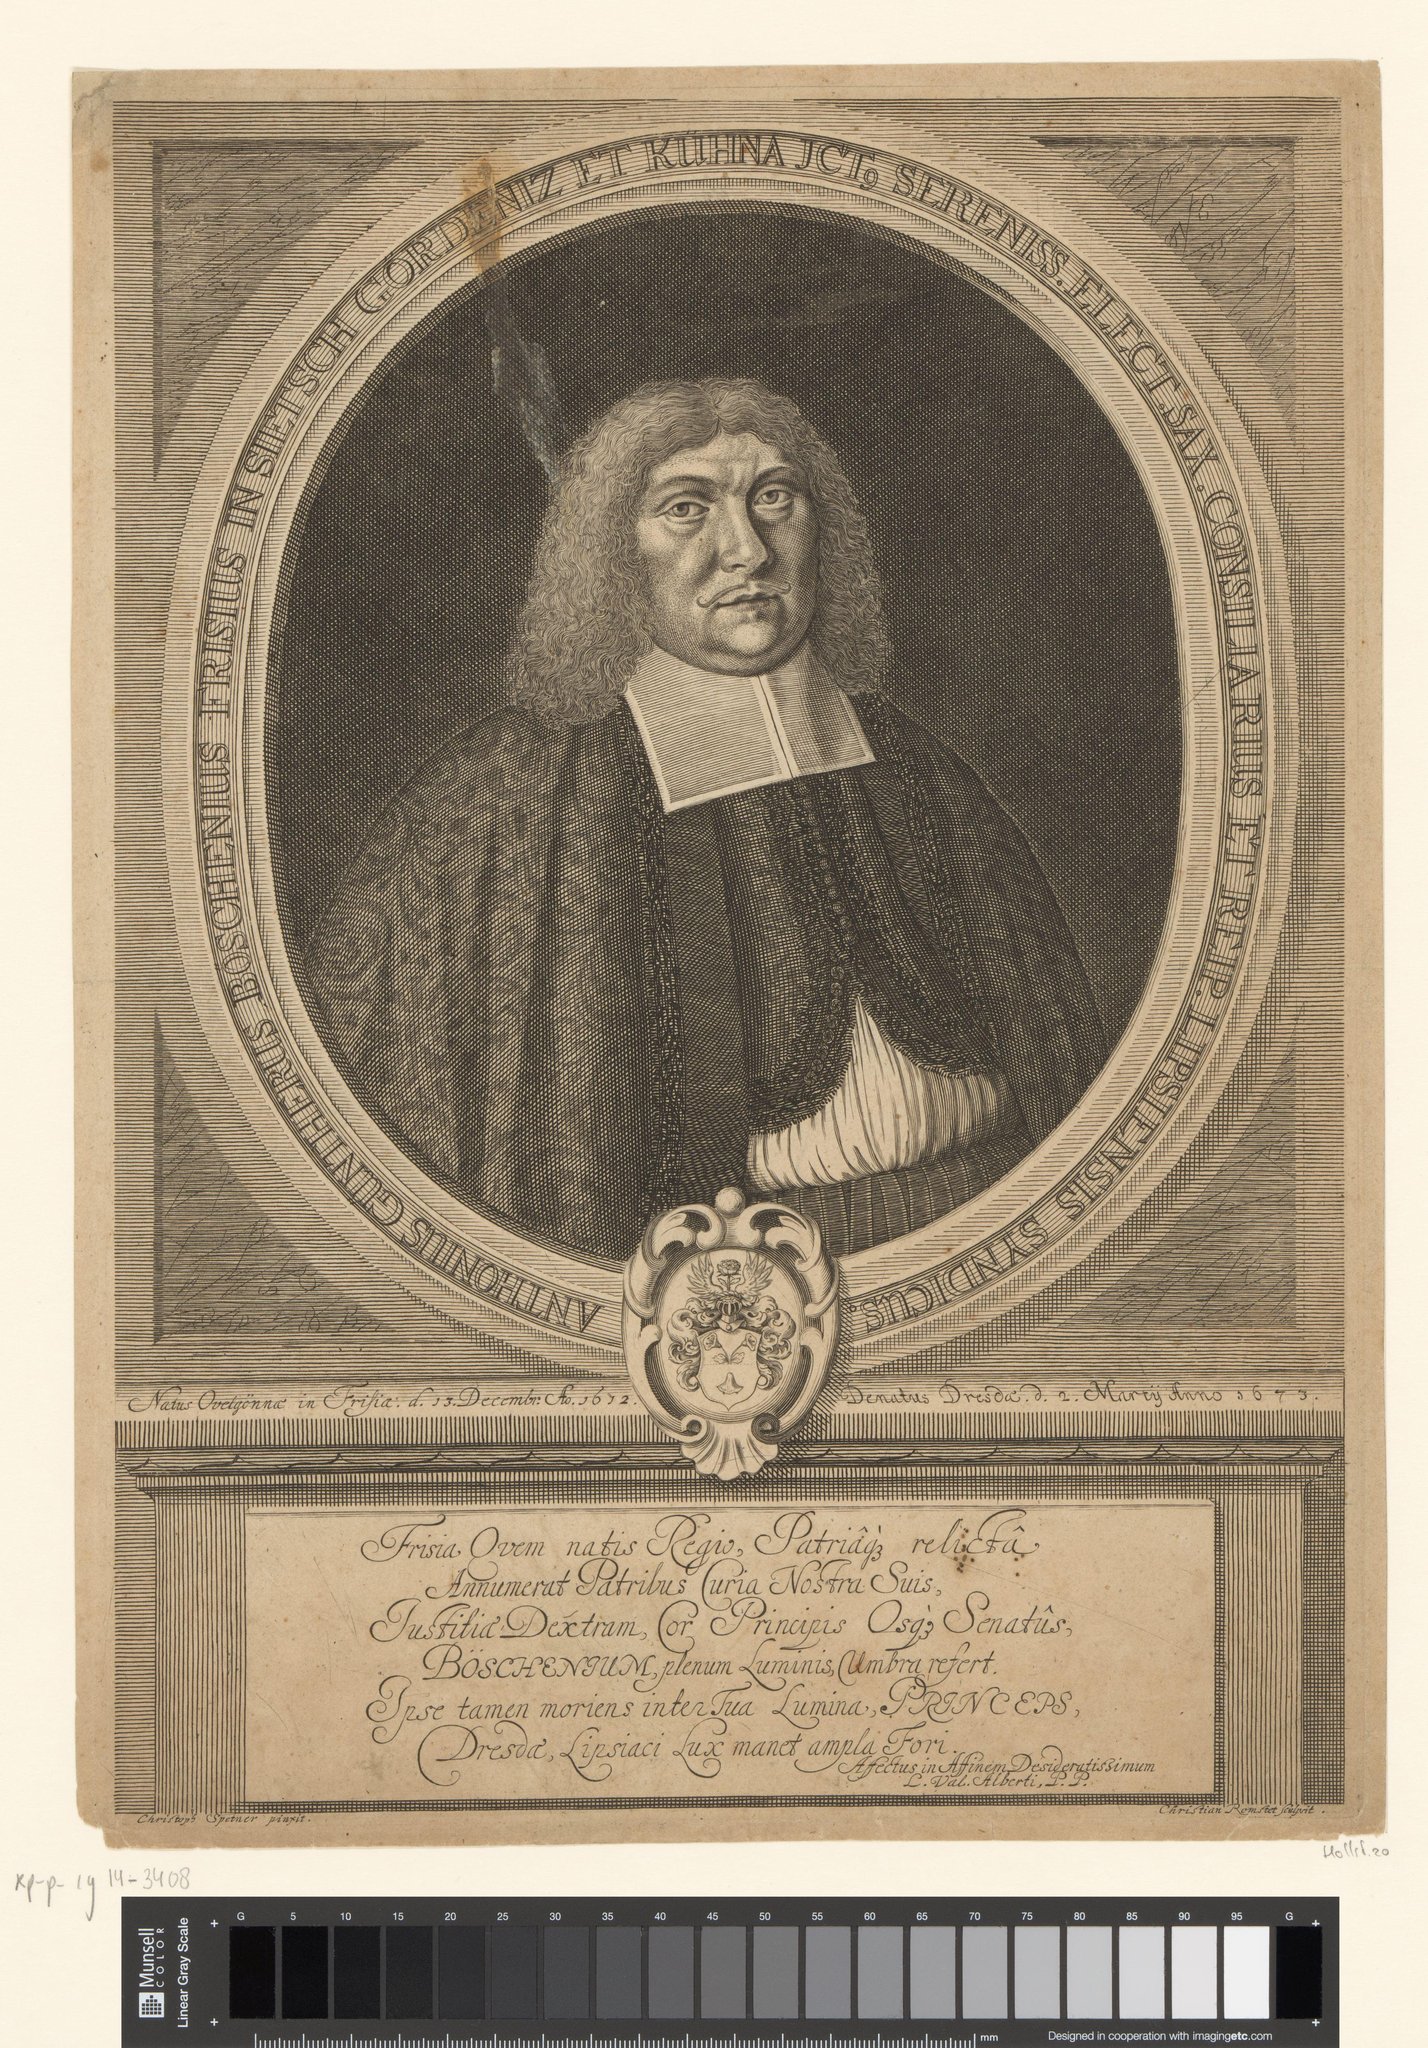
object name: print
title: Portret van Anton Günther Böschen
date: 1673-1721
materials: paper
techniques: engraving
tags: historical persons, armorial bearing, heraldry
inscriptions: collector's mark: Lugt 2228